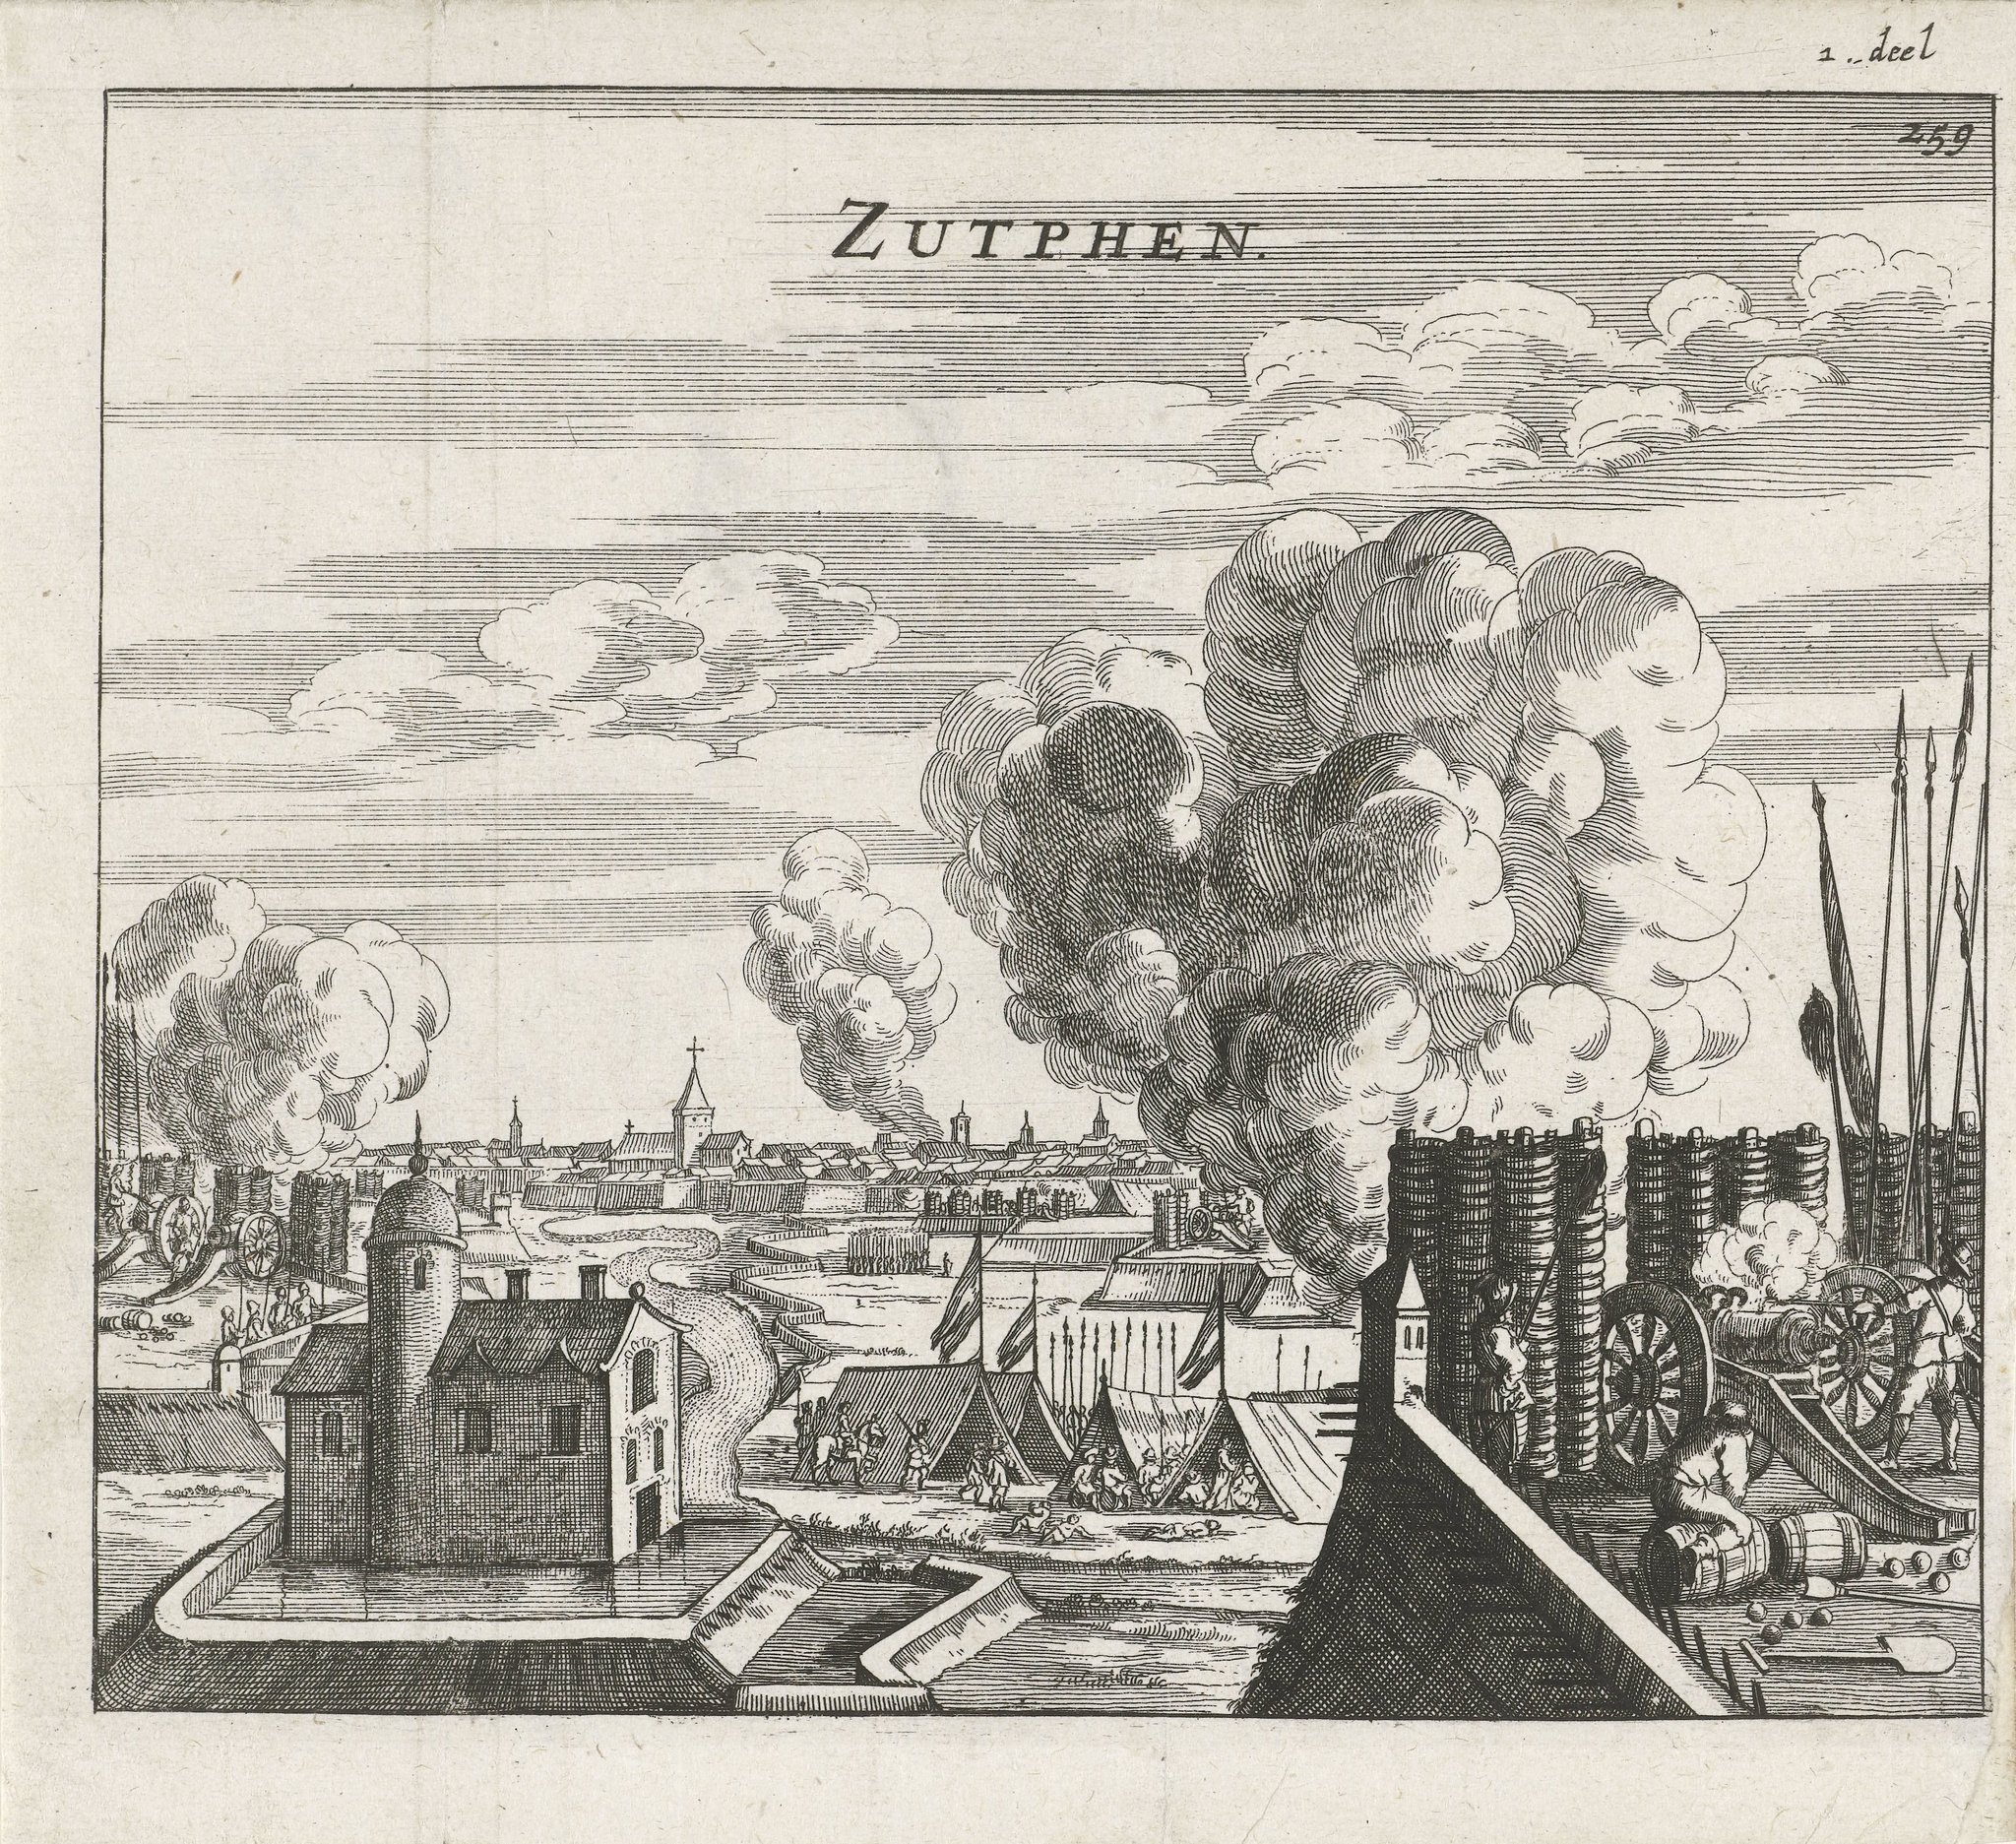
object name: history print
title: Beleg van Zutphen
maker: Anonymous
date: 1625-1699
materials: paper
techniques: etching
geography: northern netherlands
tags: siege, position war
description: lllustratie uit een onbekend werk over de militaire wapenfeiten van de prinsen van Oranje, dl. 1, p. 259.